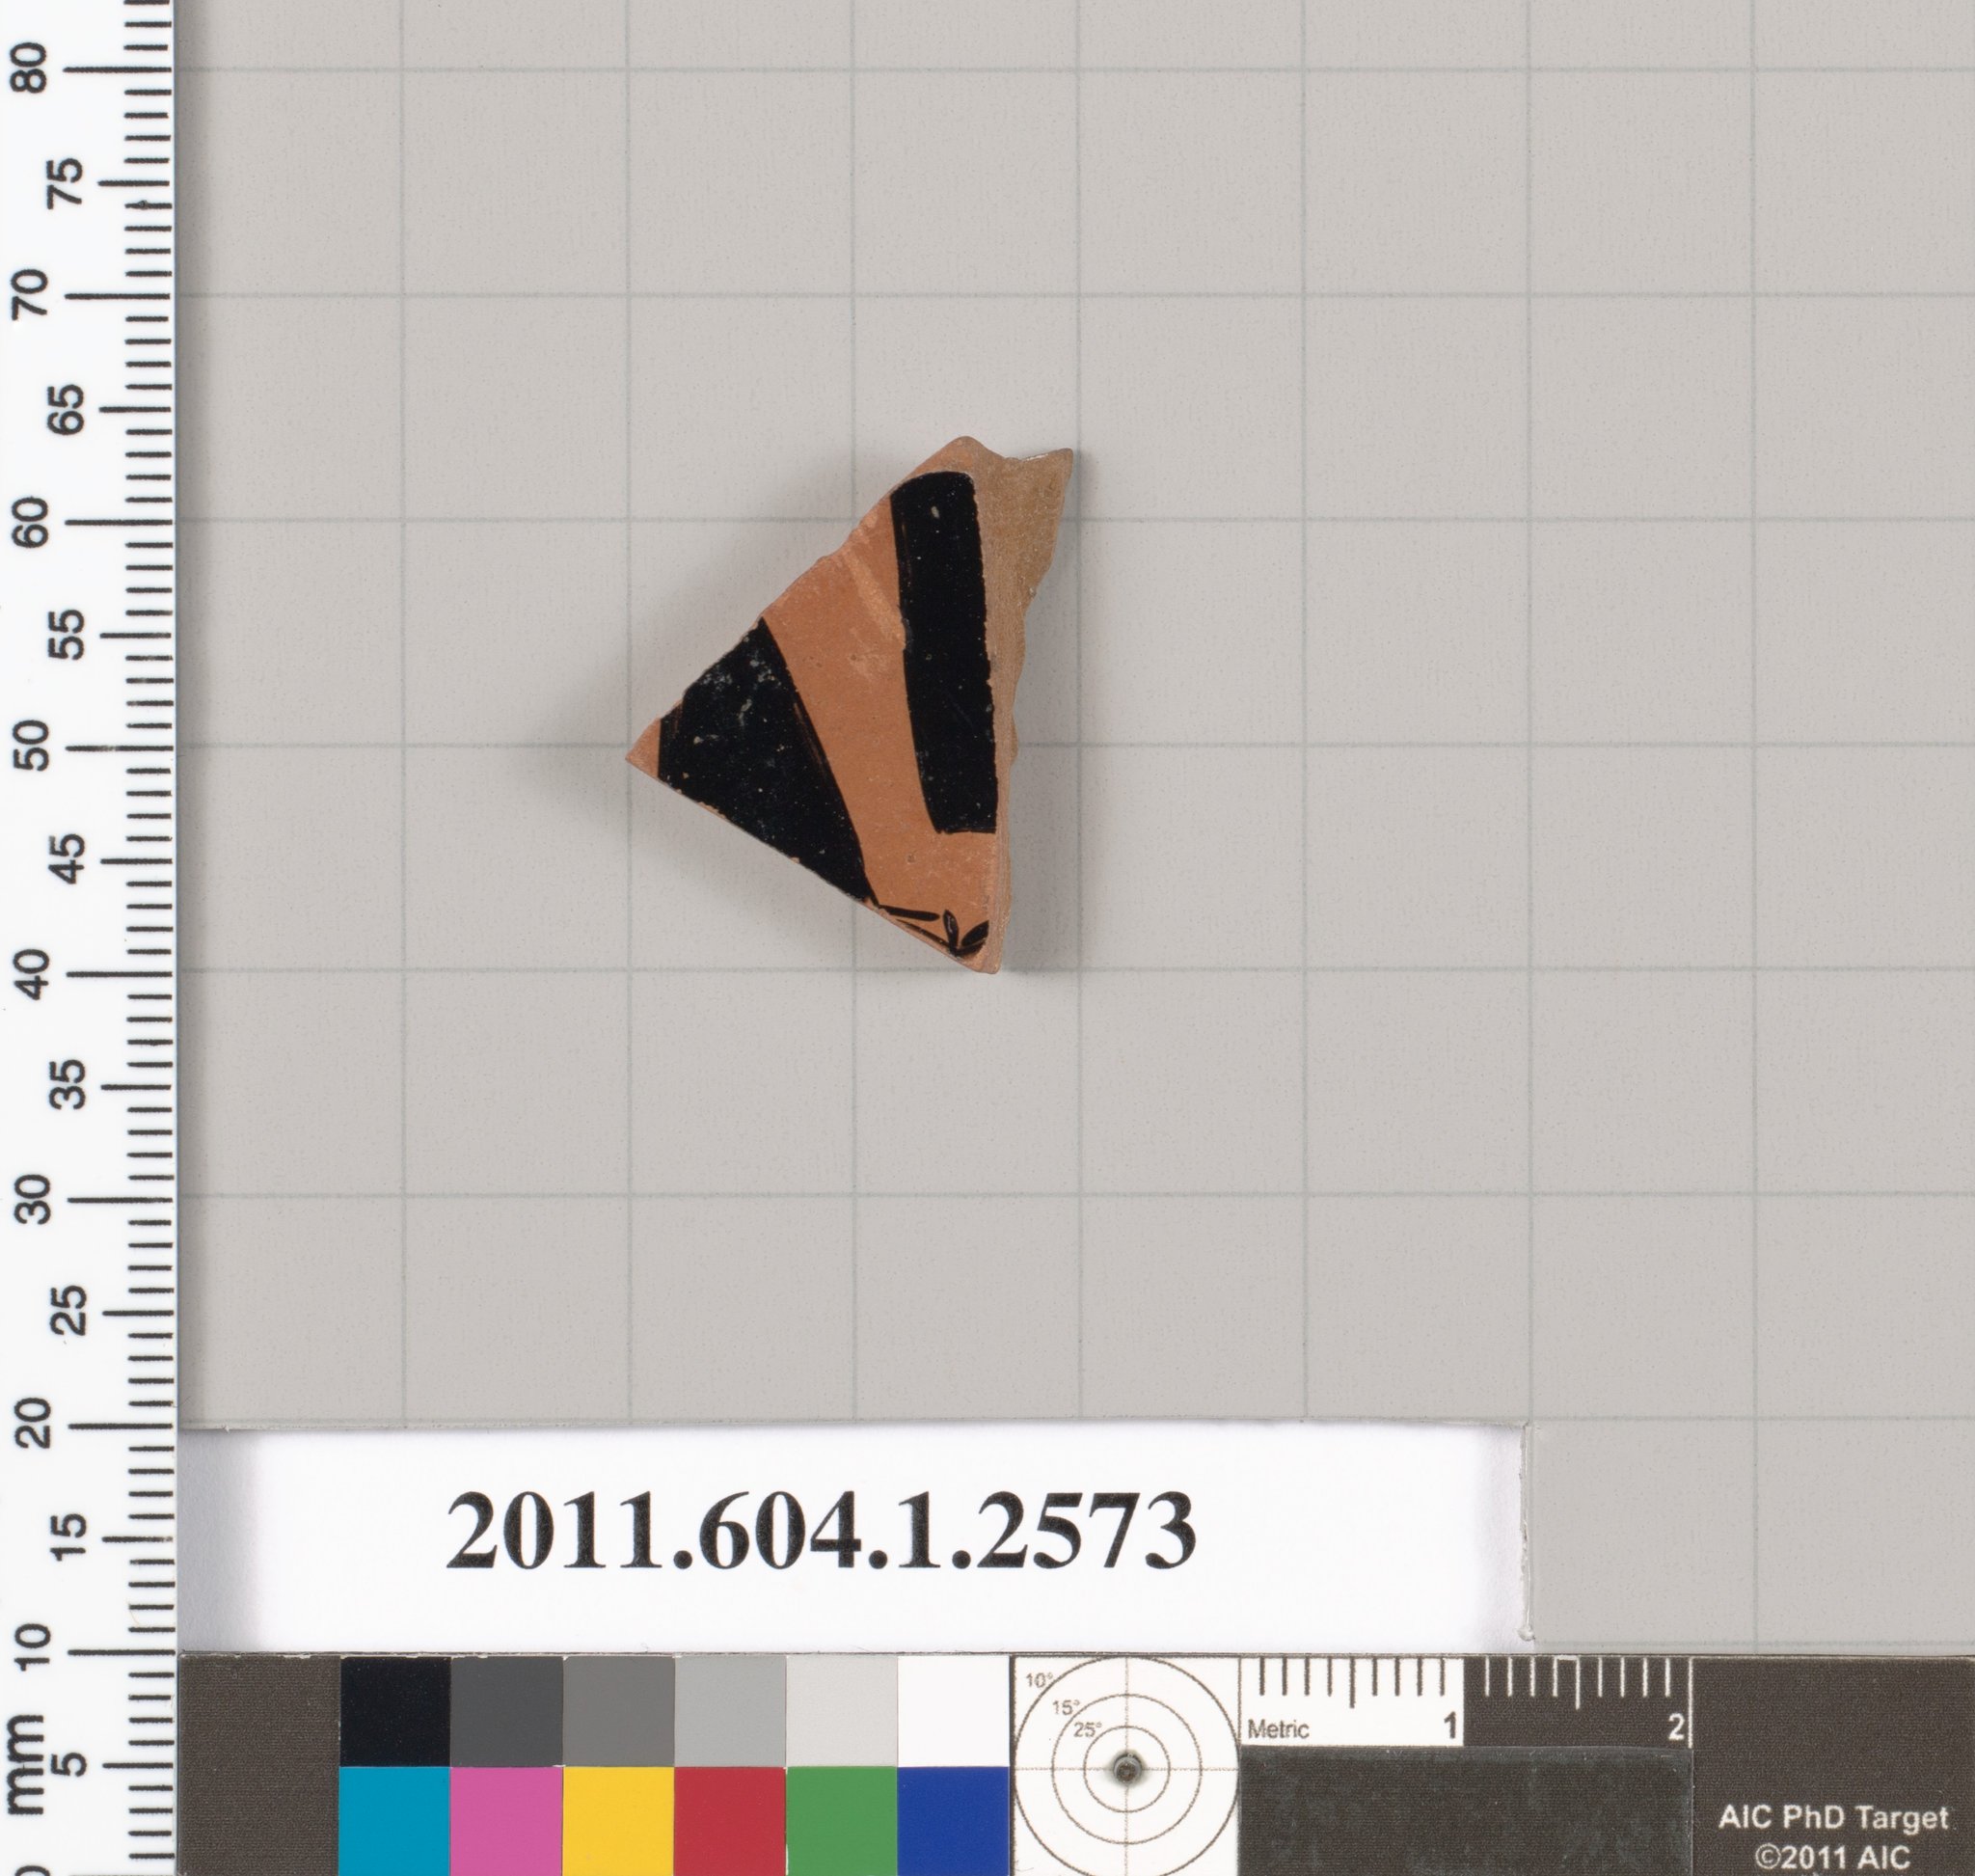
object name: kylix fragment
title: Terracotta fragment of a kylix (drinking cup)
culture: greek, attic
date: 490-480 BCE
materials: terracotta